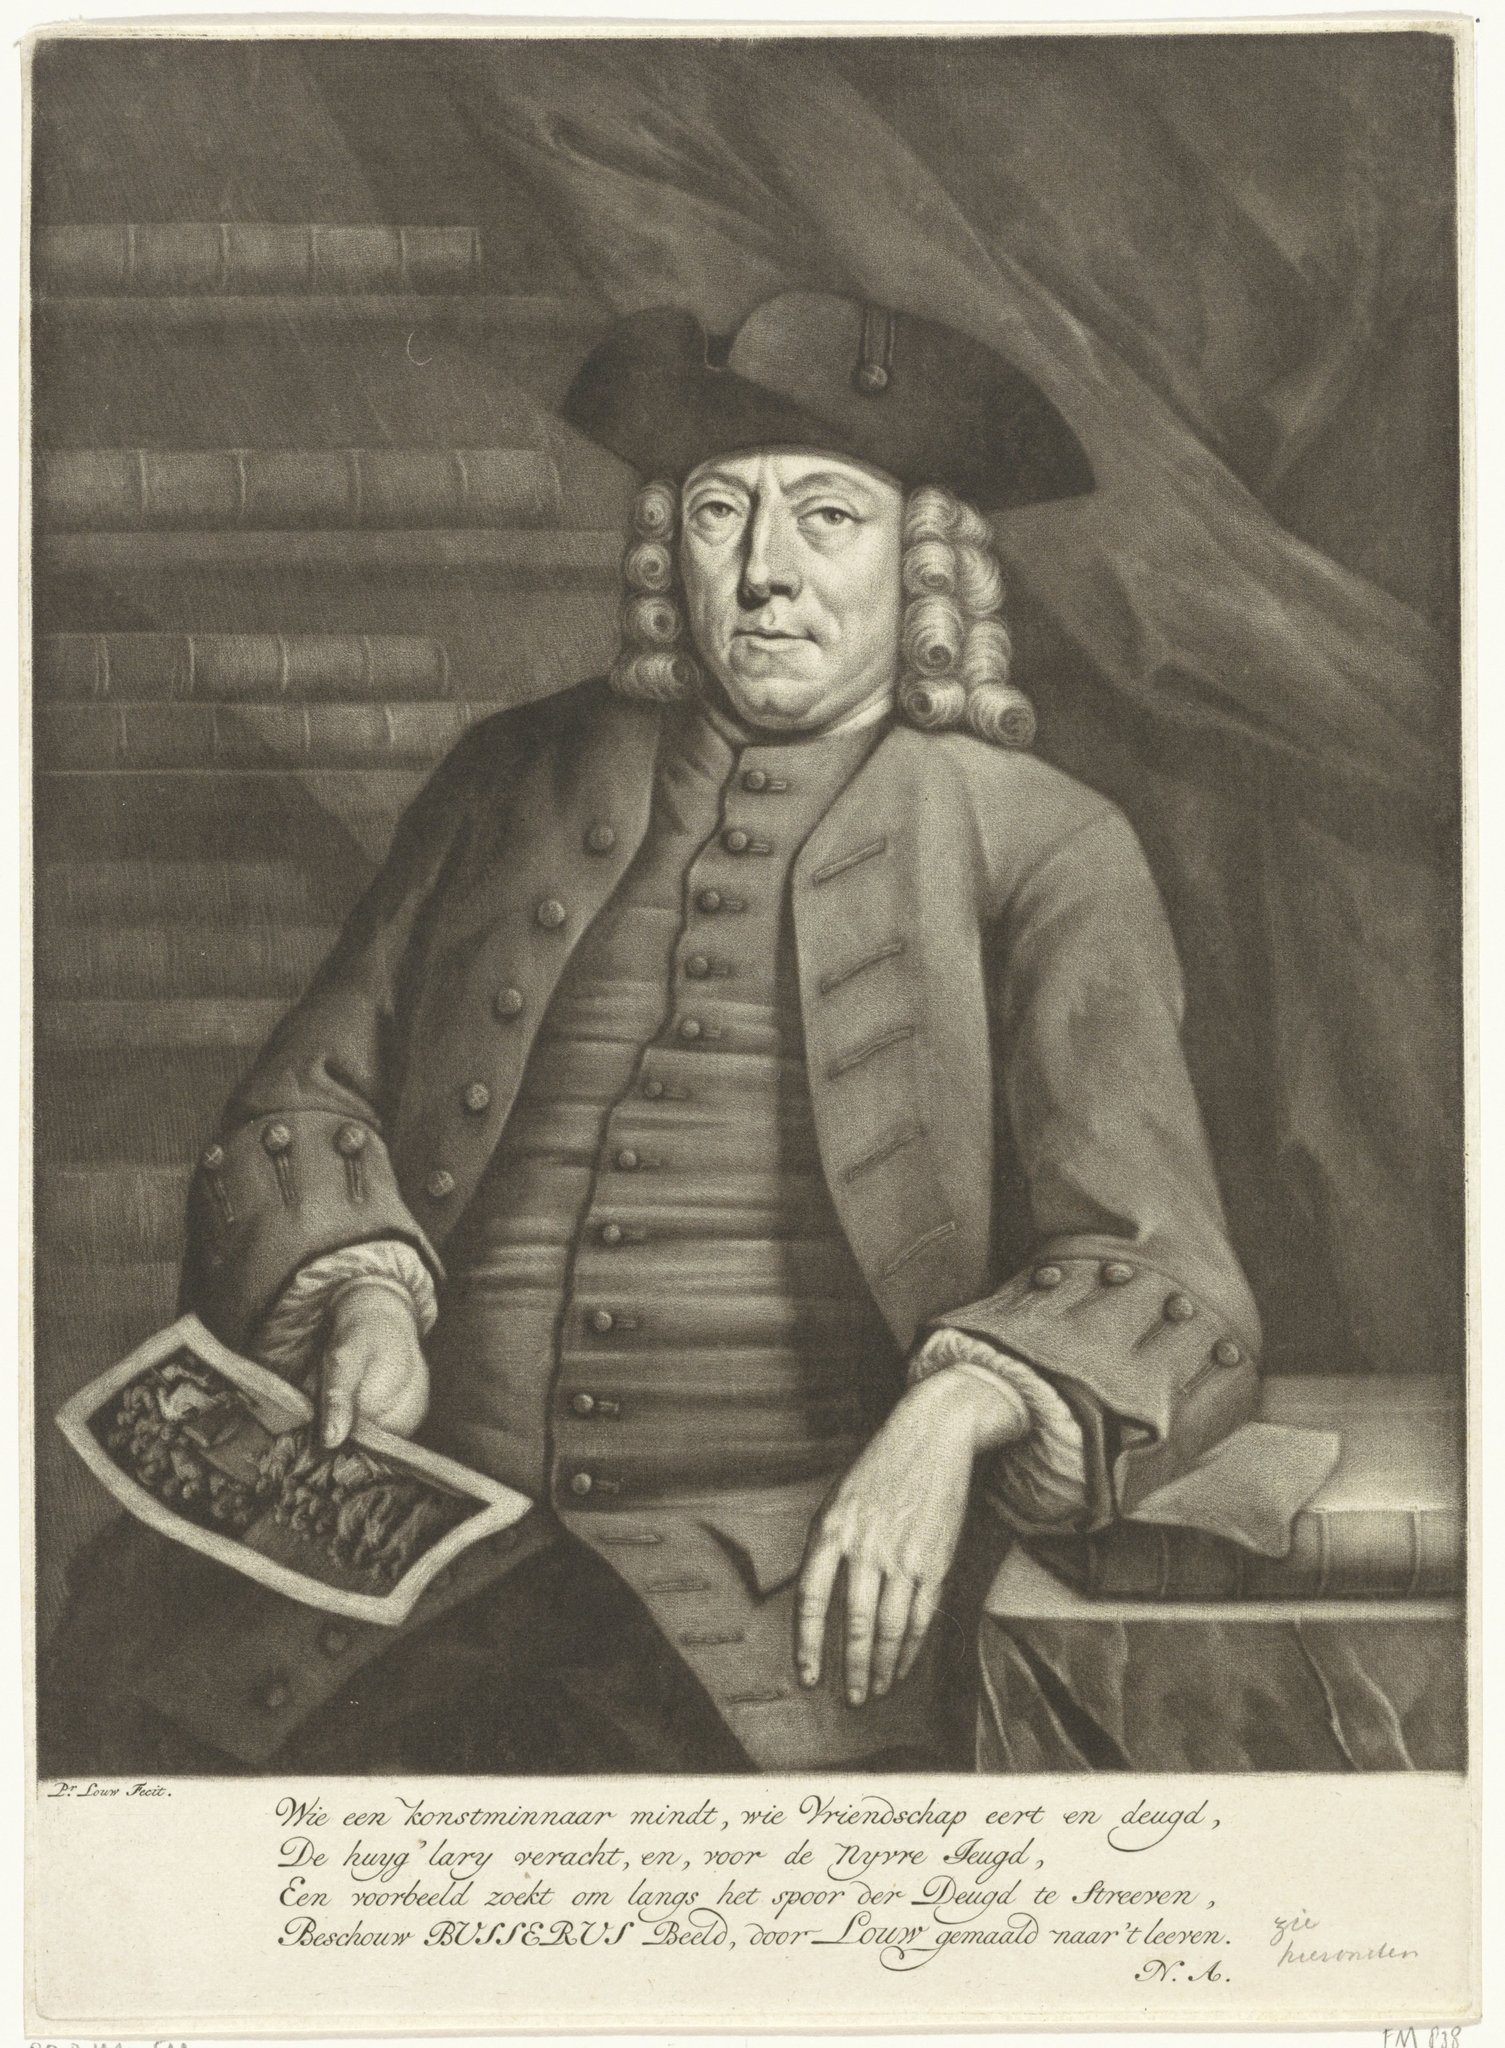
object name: print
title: Portret van Hendrik Busserus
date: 1743-1772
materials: paper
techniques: engraving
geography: amsterdam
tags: christ's dispute with the doctors in the temple; he counts his arguments on his fingers, art collector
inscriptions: collector's mark: Lugt 2228, collector's mark: Lugt 2760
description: De kunstverzamelaar en graveur Hendrik Busserus met in de hand een prent door Rembrandt Harmensz. van Rijn en Pieter Louw met 'Christus in de tempel'. Busserus zit naast een tafel voor een geopende kunstkast. In de marge een vier-regelig gedicht over de geportretteerde als voorbeeld voor de jeugd.